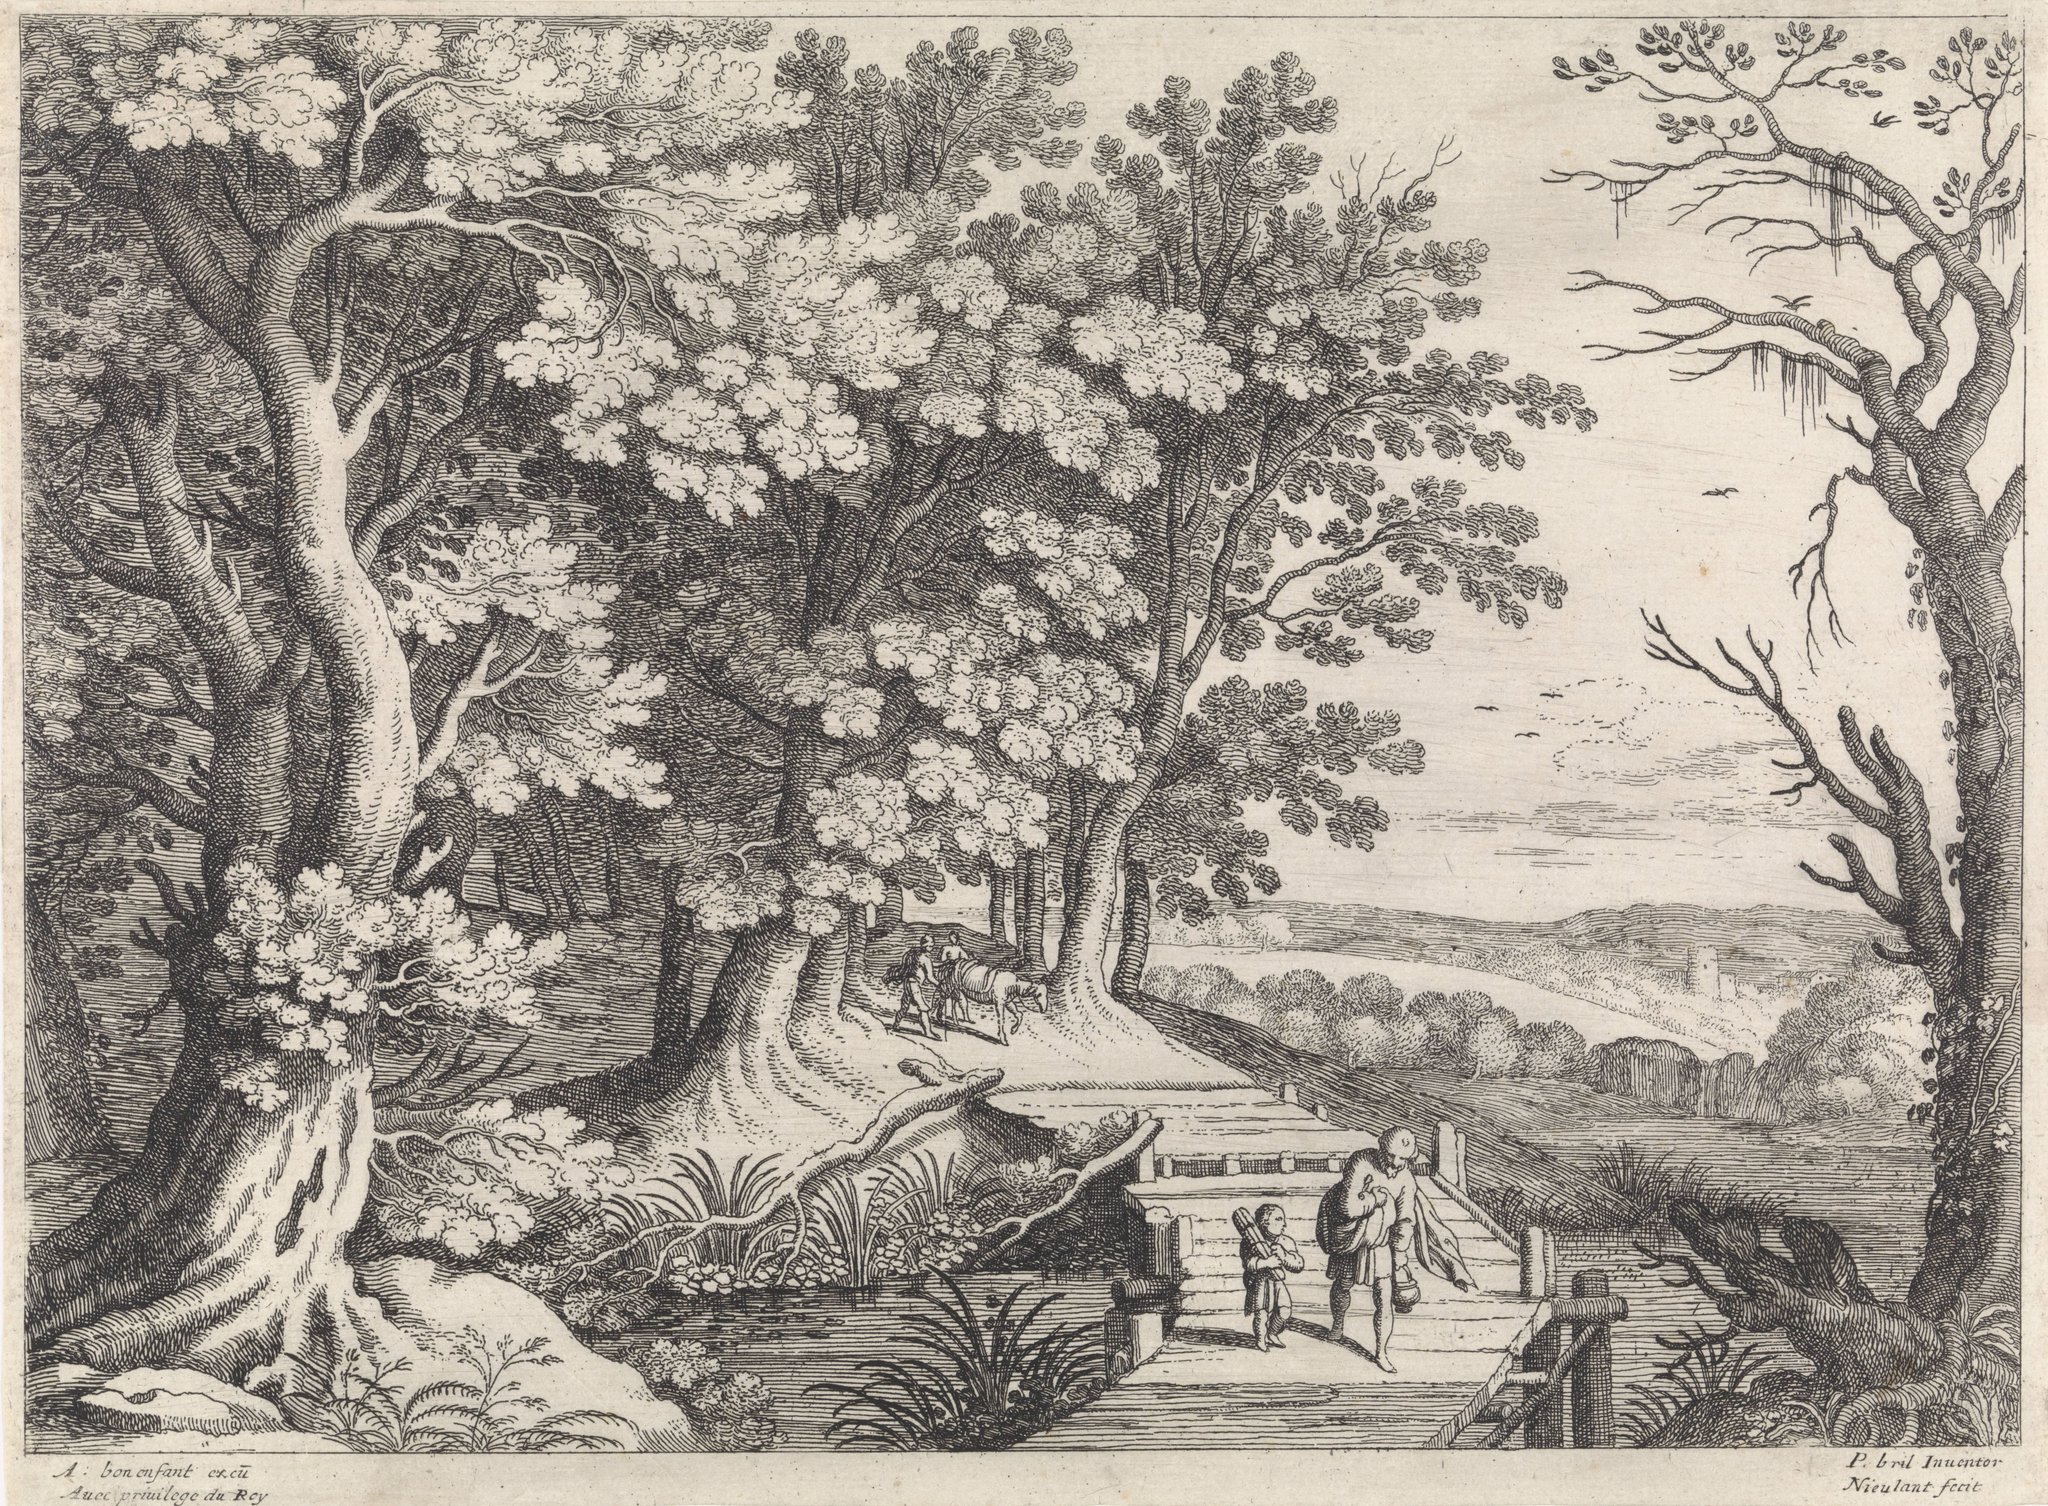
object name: print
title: Italiaanse landschappen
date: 1594-1635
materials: paper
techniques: etching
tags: landscapes in the temperate zone, the servants are left behind while abraham and isaac (usually carrying wood) climb the mountain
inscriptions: collector's mark: Lugt 2228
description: Abraham en zijn zoon Isaak, die het hout draagt, lopen over een houten brug in een bebost en heuvelachtig landschap naar de offerplaats. De twee knechten en de ezel hebben zij achter zich gelaten. Prent uit een serie Italiaanse landschappen.